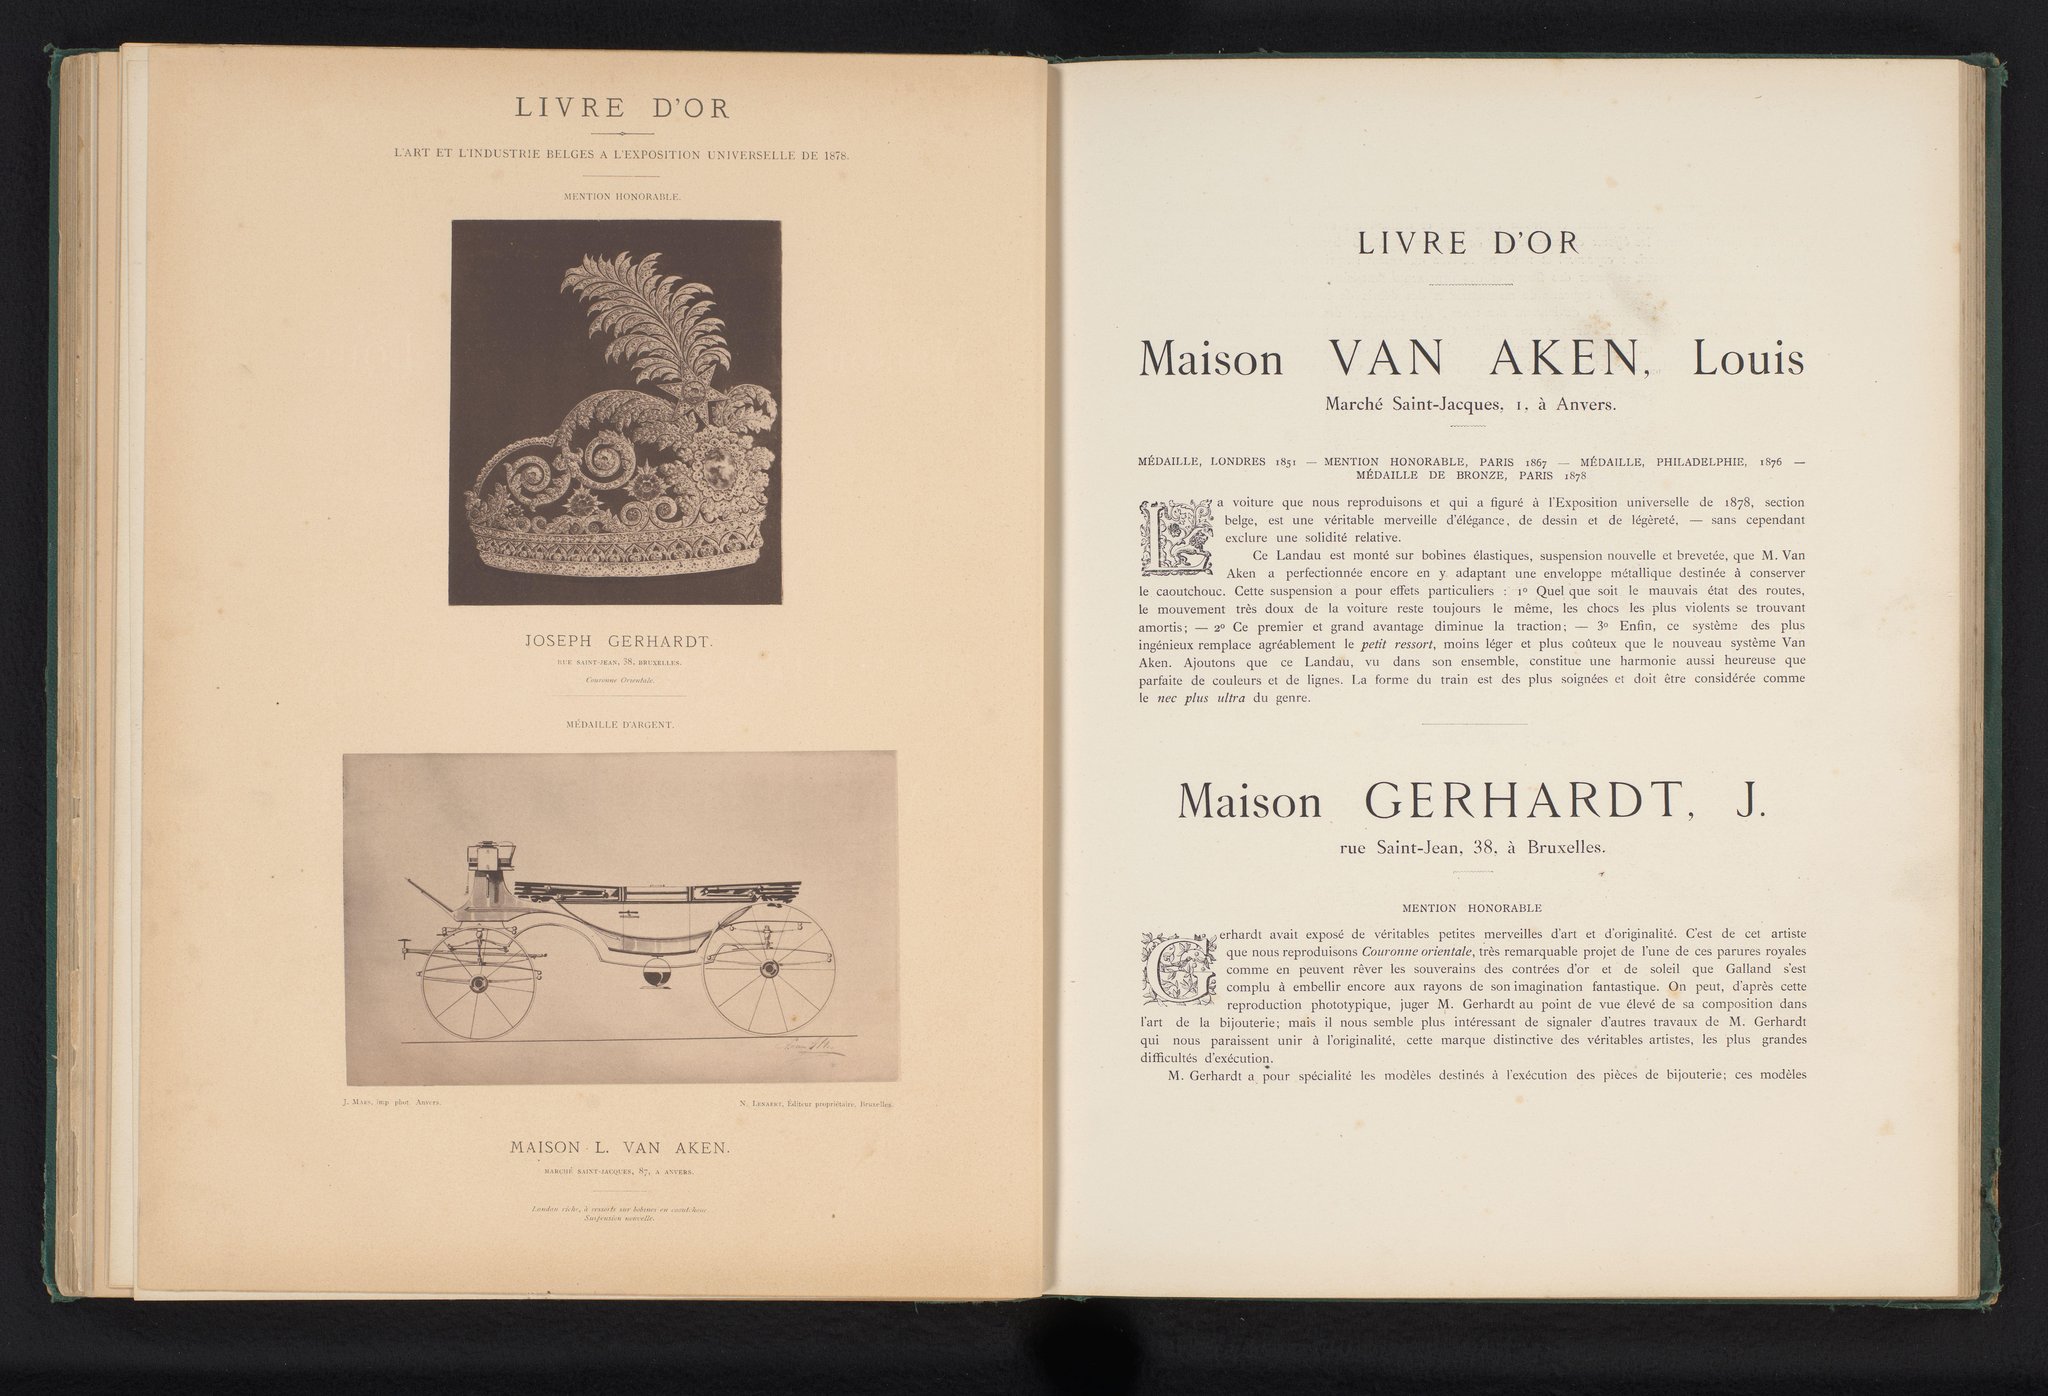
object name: page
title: Opnamen van een Aziatische kroon en een reproductie van een ontwerp van een luxe kinderwagen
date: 1874-1879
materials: paper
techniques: photograph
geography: brussels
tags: baby-carriage, pram, perambulator, crown (symbol of sovereignty)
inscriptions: inscription: ‘Joseph Gerhardt/ Maison L. van Aken’, inscription: ‘Livre d'or/ L'art et l'industrie Belges a l'exposition universelle de 1878.’